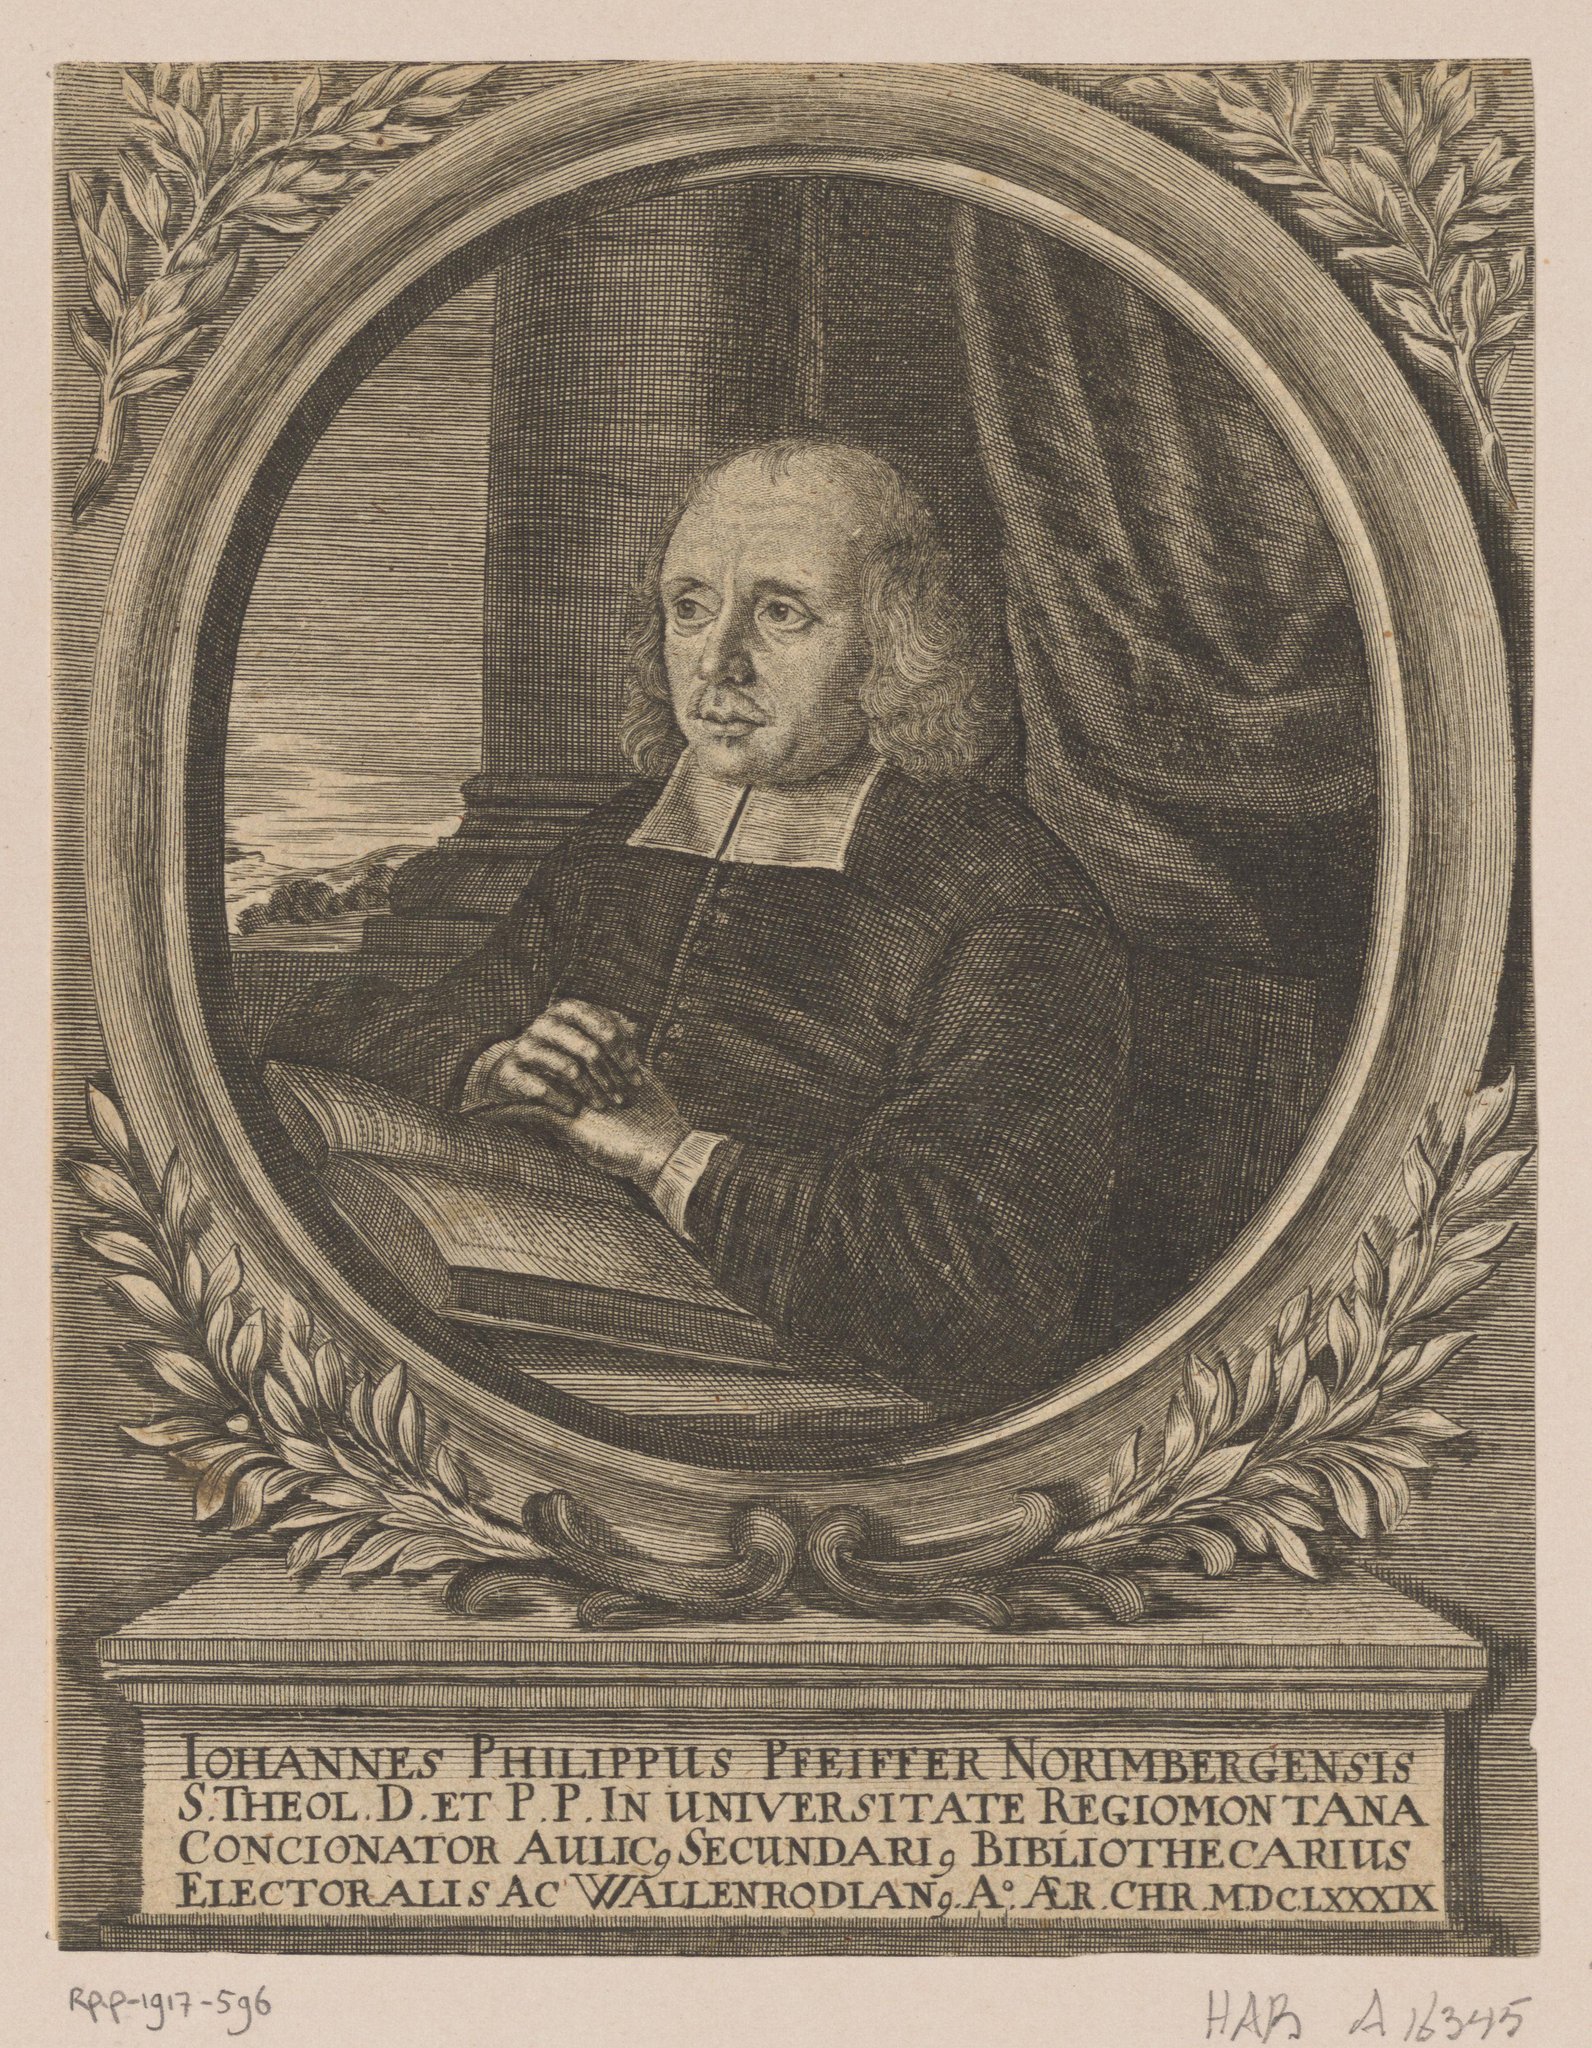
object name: print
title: Portret van Johann Philipp Pfeiffer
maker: Anonymous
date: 1689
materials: paper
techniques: engraving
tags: adult man, historical persons, book - mm - book open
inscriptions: collector's mark: Lugt 2228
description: Prent mogelijk uit: Pfeiffer, Johann Philipp. Libri IV Antiquitatum Graecarum Gentilium Sacrarum, Politicarum, Militarium, & Oeconomicarum. Koningsbergen en Leipzig: Heinrich Boye, 1689.